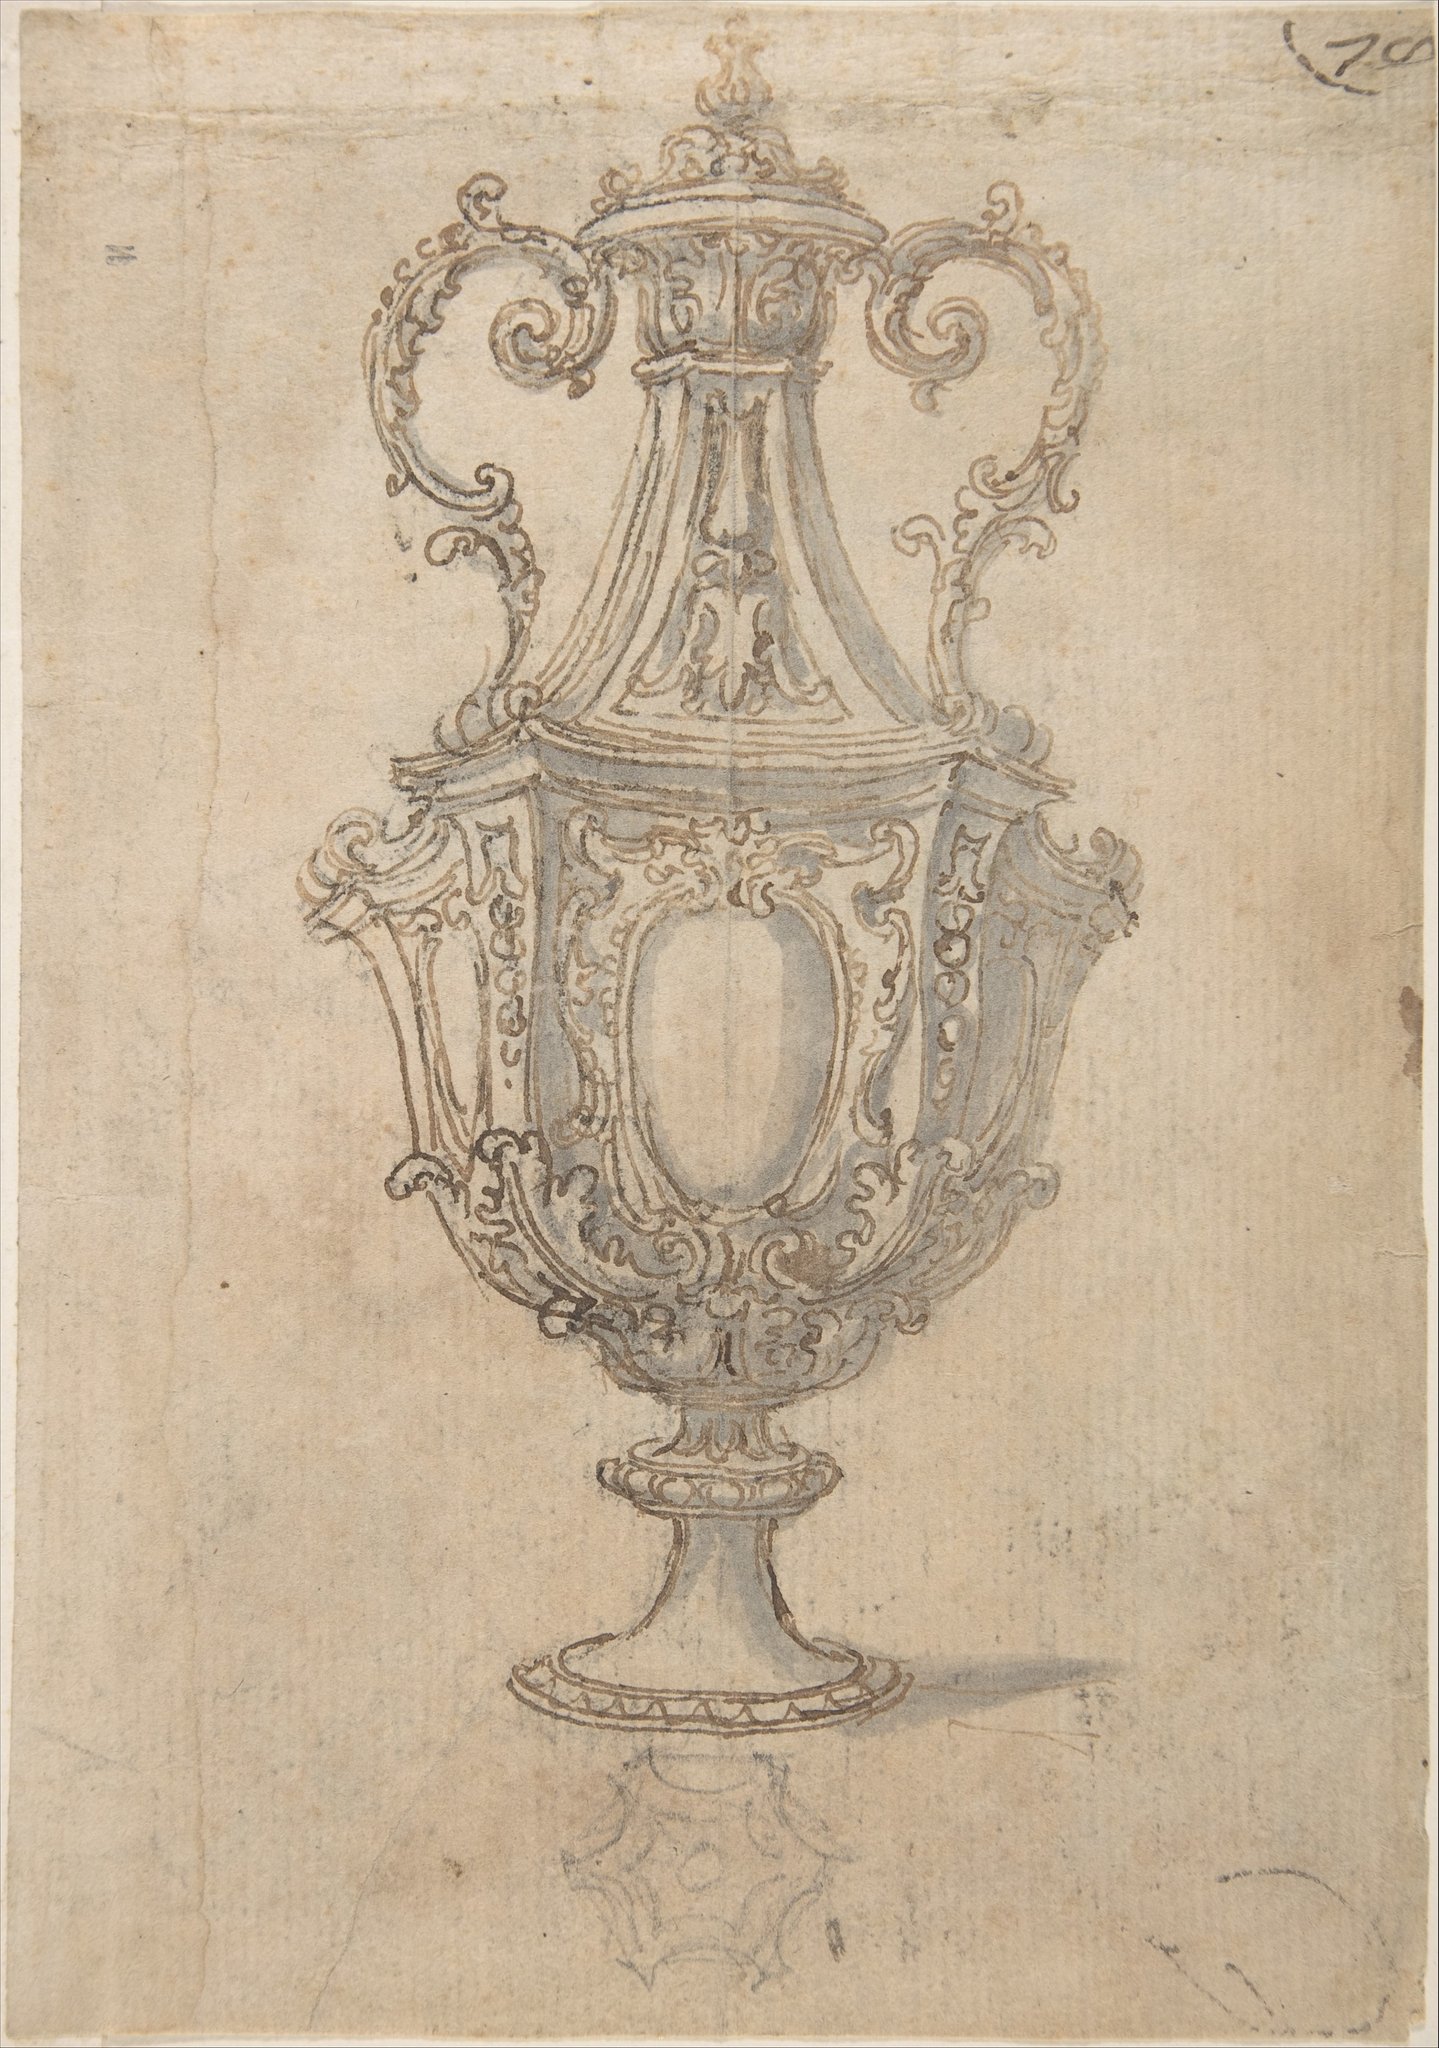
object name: drawing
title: Design for a Vase with a Cross-section of its Neck (recto); Design for a Vase with studies of a Muscular Nude Male Figure and figures for a Baptism (verso)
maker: giovanni battista foggini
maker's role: artist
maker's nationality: italian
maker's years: 1652-1725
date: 1672-1725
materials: chalk, ink, drawing material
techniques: brush, pen, wash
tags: vases